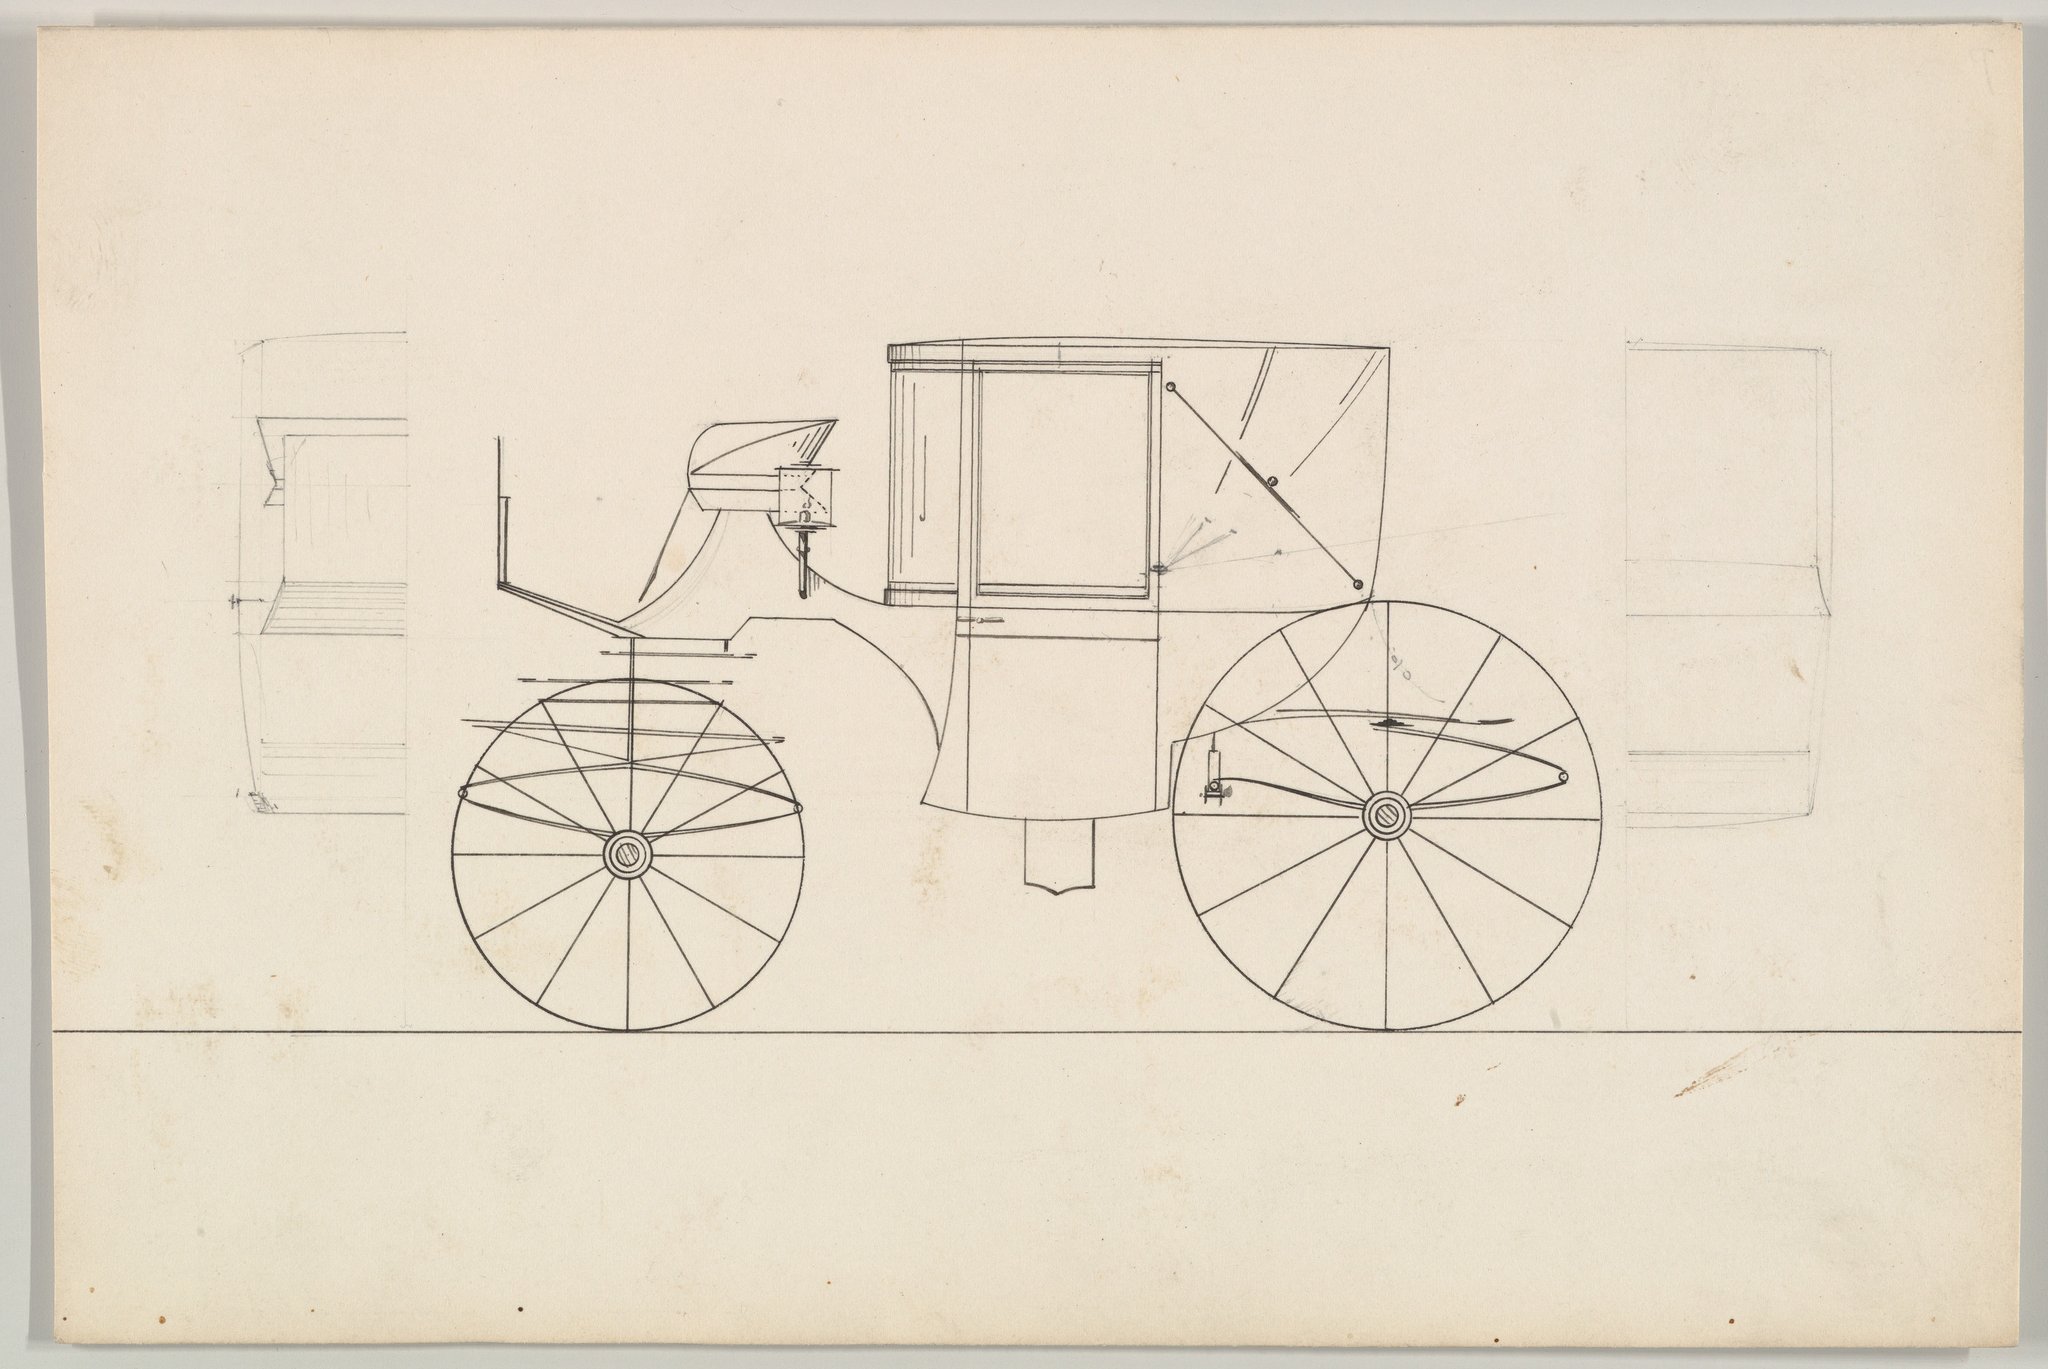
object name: drawing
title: Design for Double Front Landaulet (unnumbered)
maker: brewster & co.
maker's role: manufacturer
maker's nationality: american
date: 1850-1870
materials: graphite, ink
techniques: pen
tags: carriages